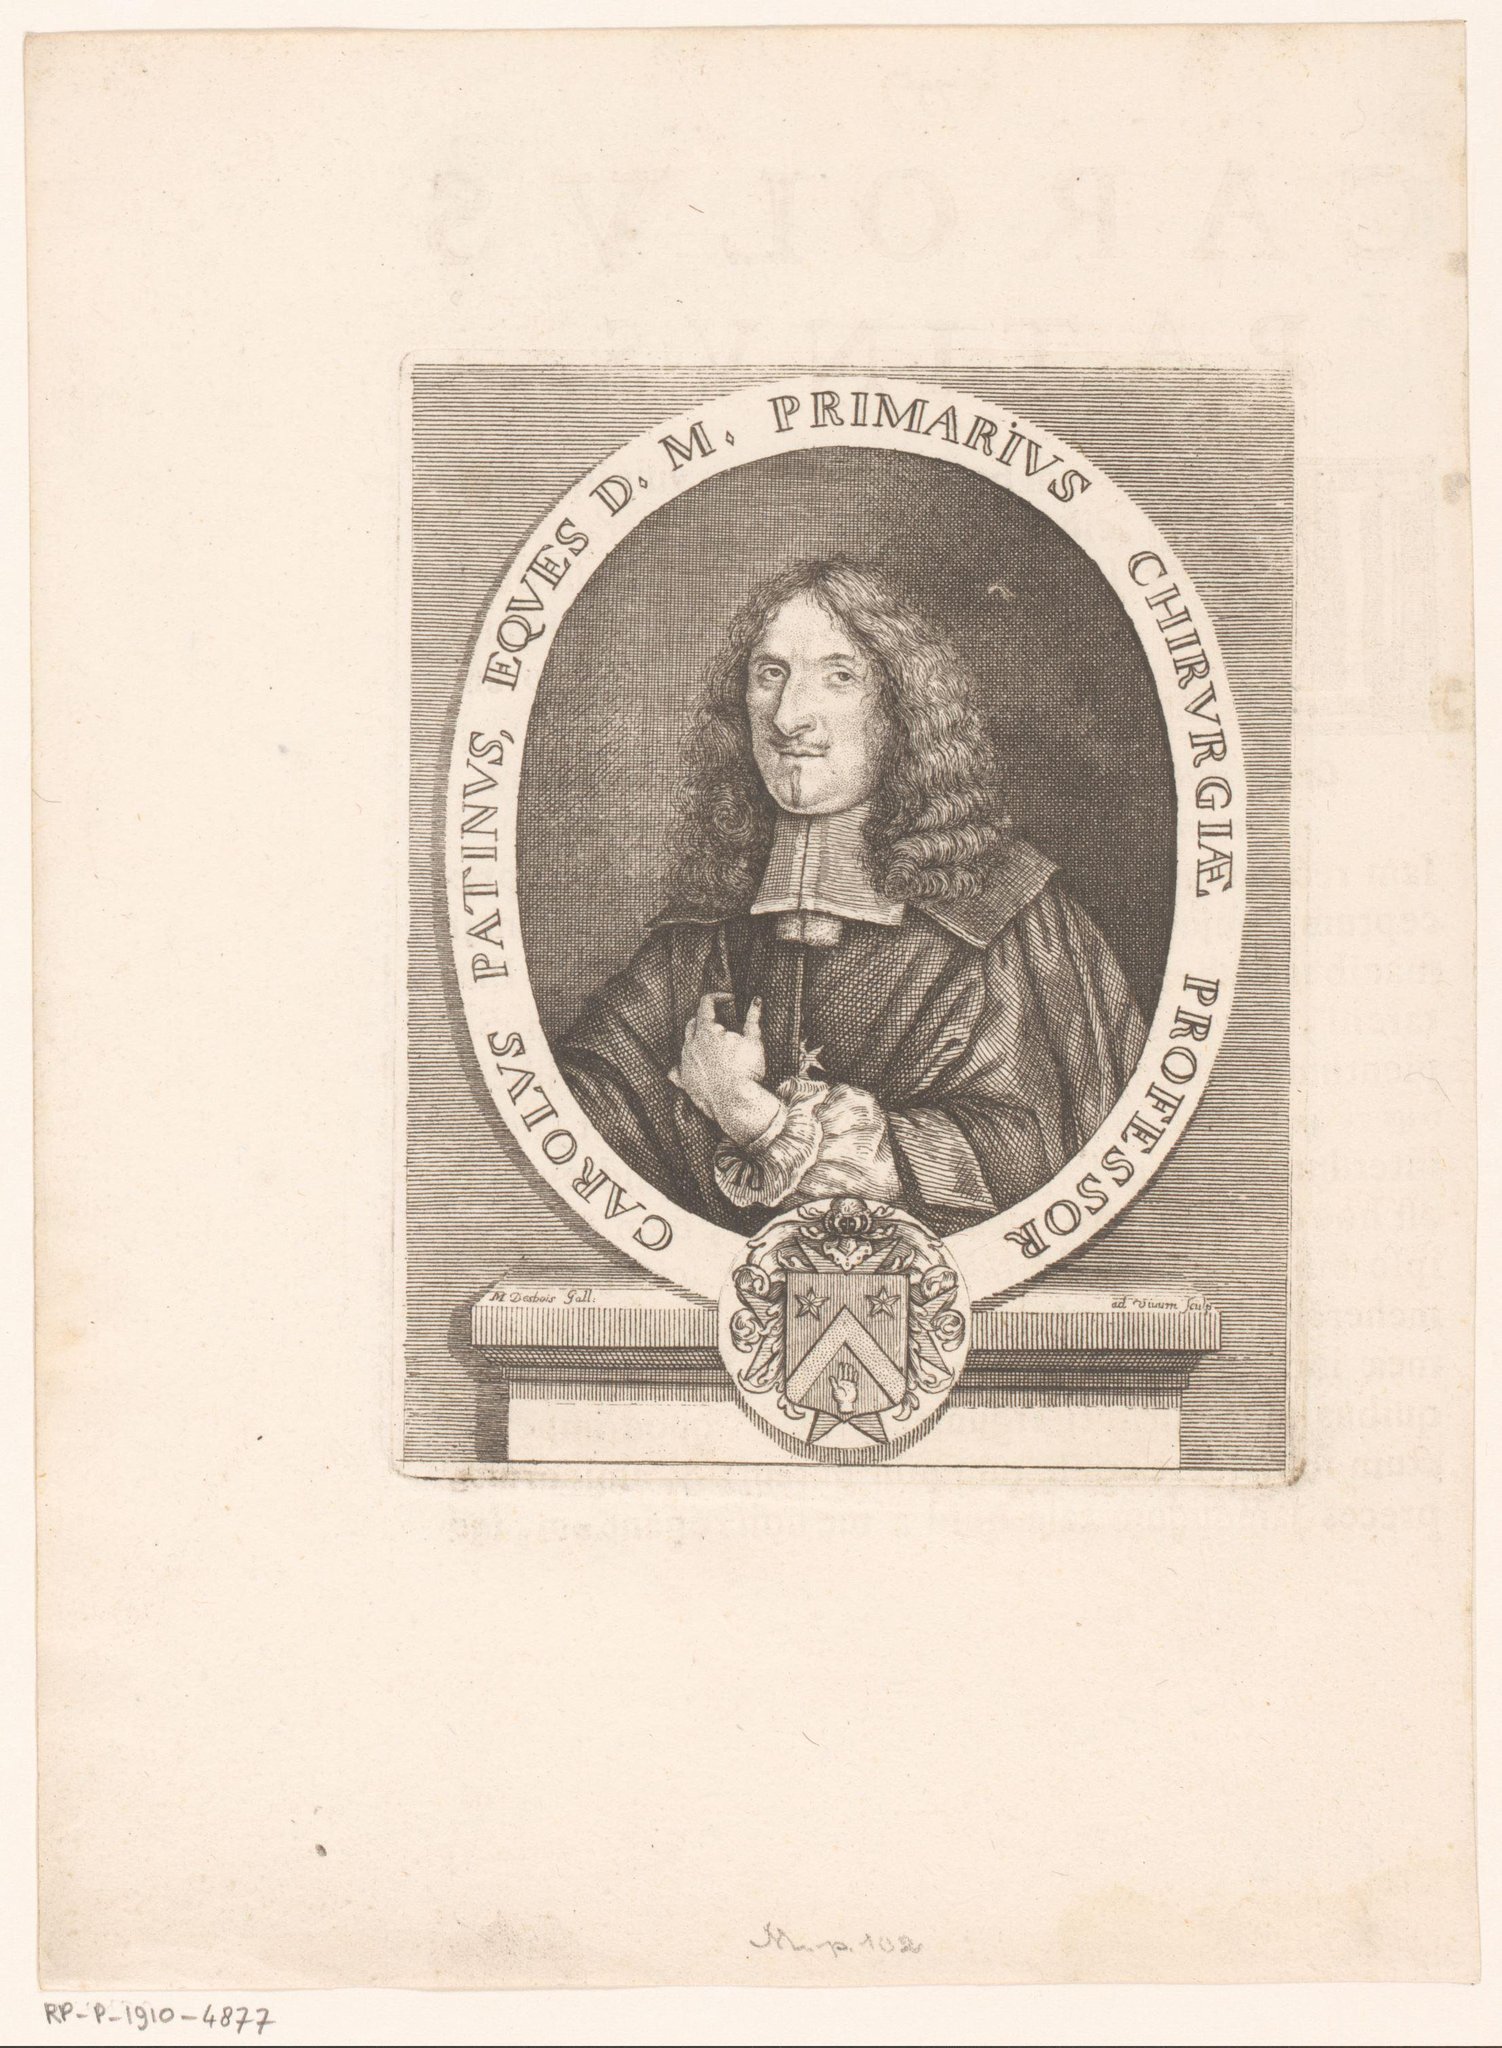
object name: book illustration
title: Portret van Charles Patin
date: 1682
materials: paper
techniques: engraving, etching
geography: padua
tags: charles patin, historical persons, professor, armorial bearing, heraldry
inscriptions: collector's mark: Lugt 2228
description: Prent uit: Patin, Charles. Lyceum Patavinum: sive icones et vitae professorum. Padua: Frambotti, Petri Mariae, 1682.